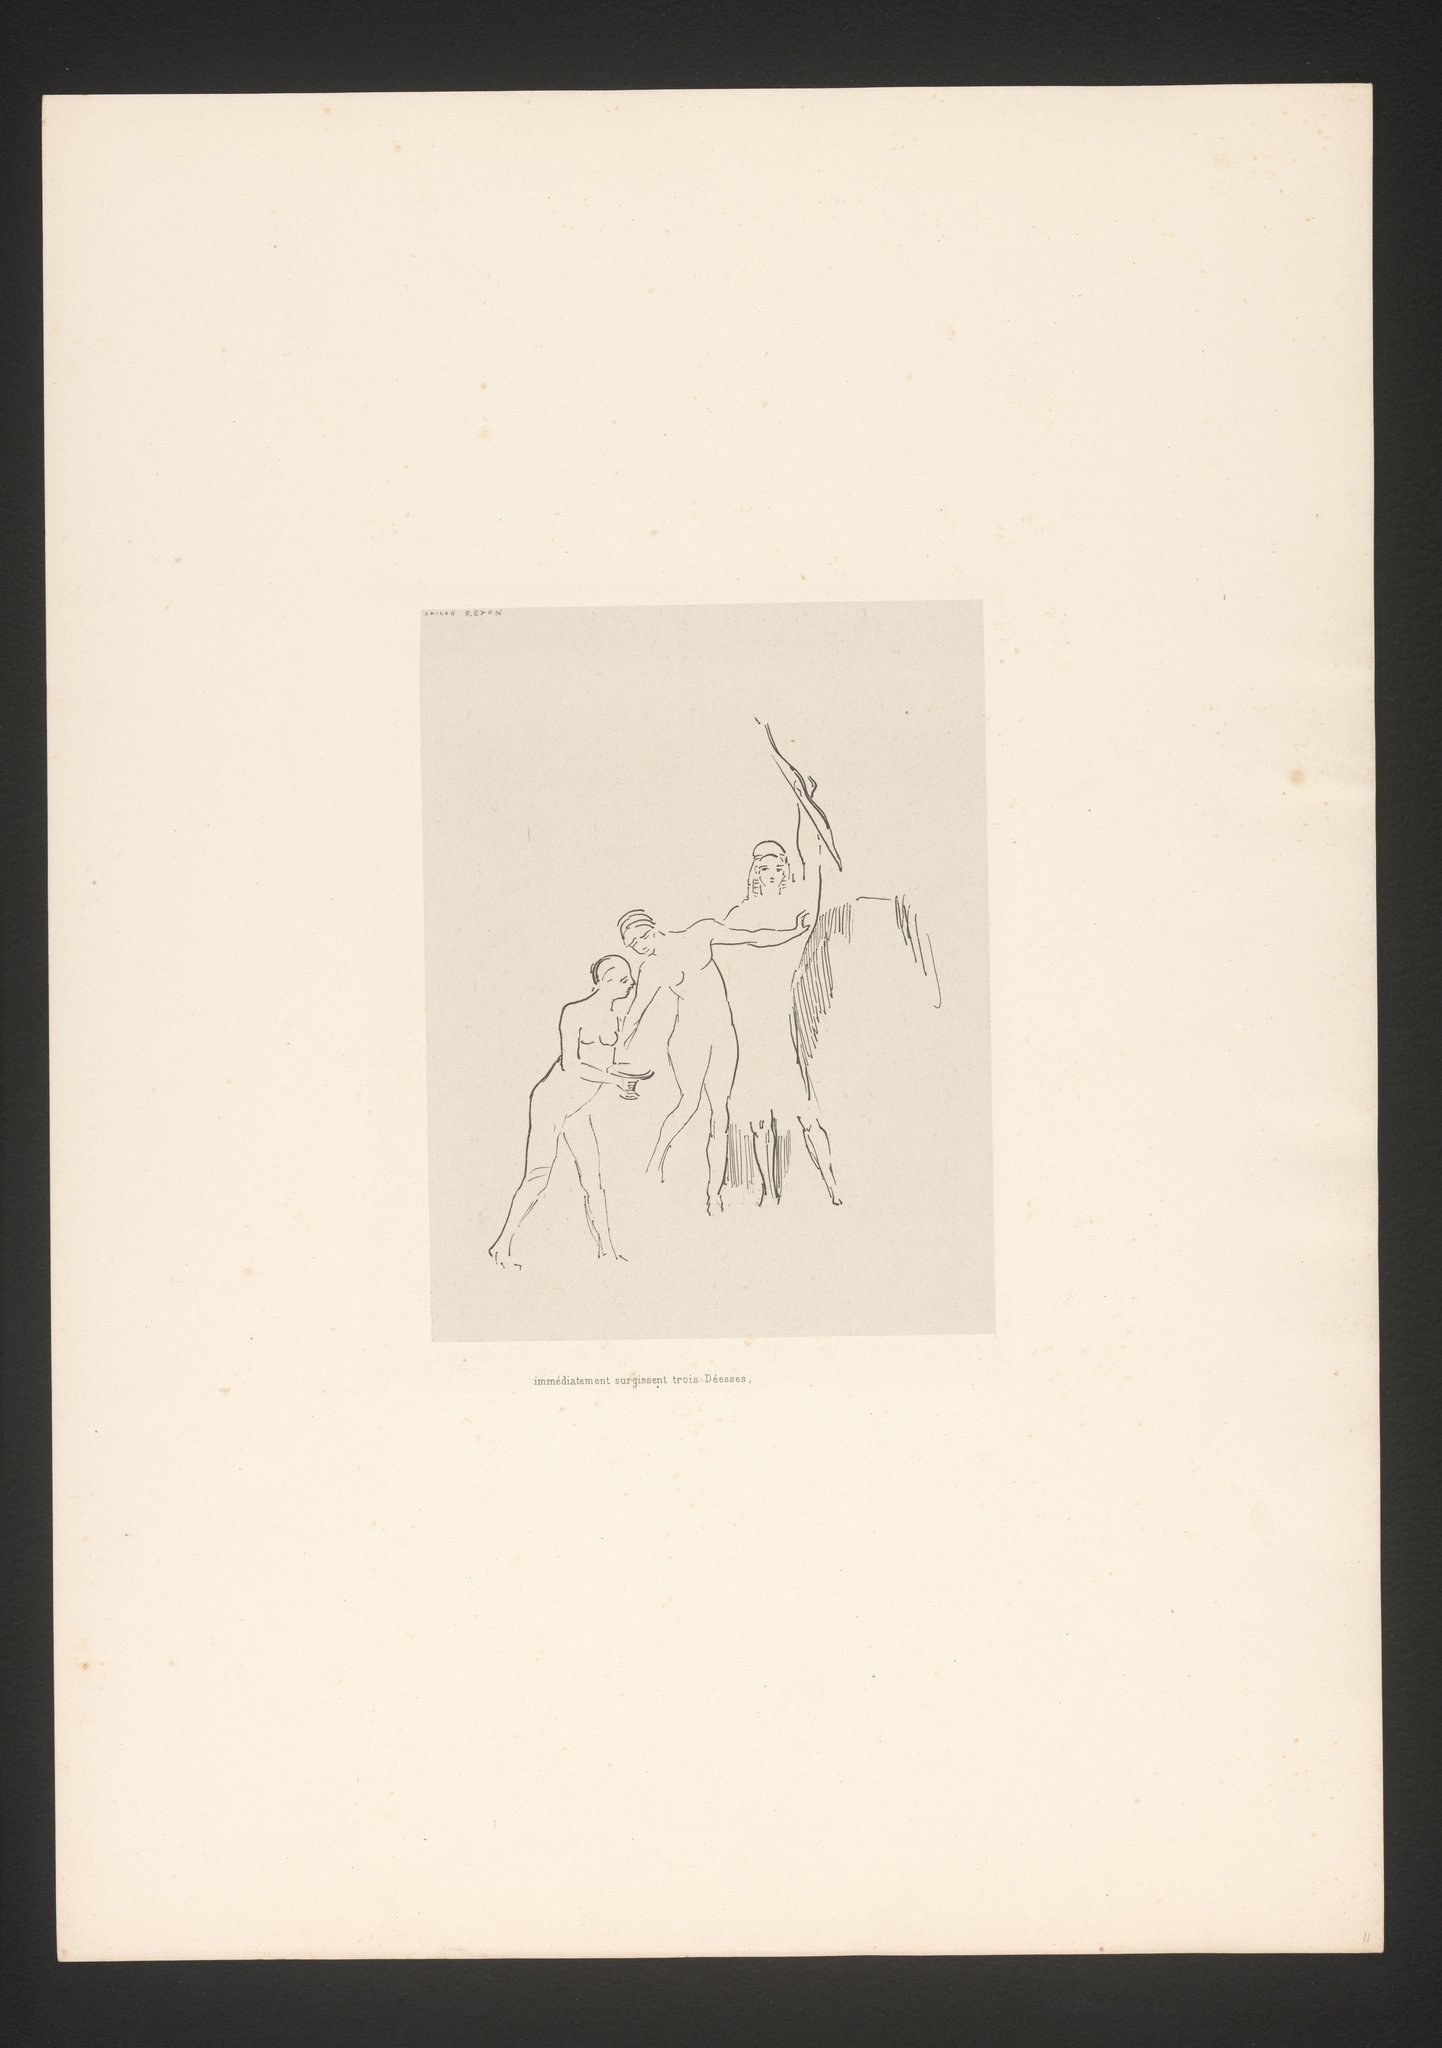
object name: print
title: Drie klassieke godinnen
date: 1896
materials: paper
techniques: lithograph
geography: paris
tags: female roman deities